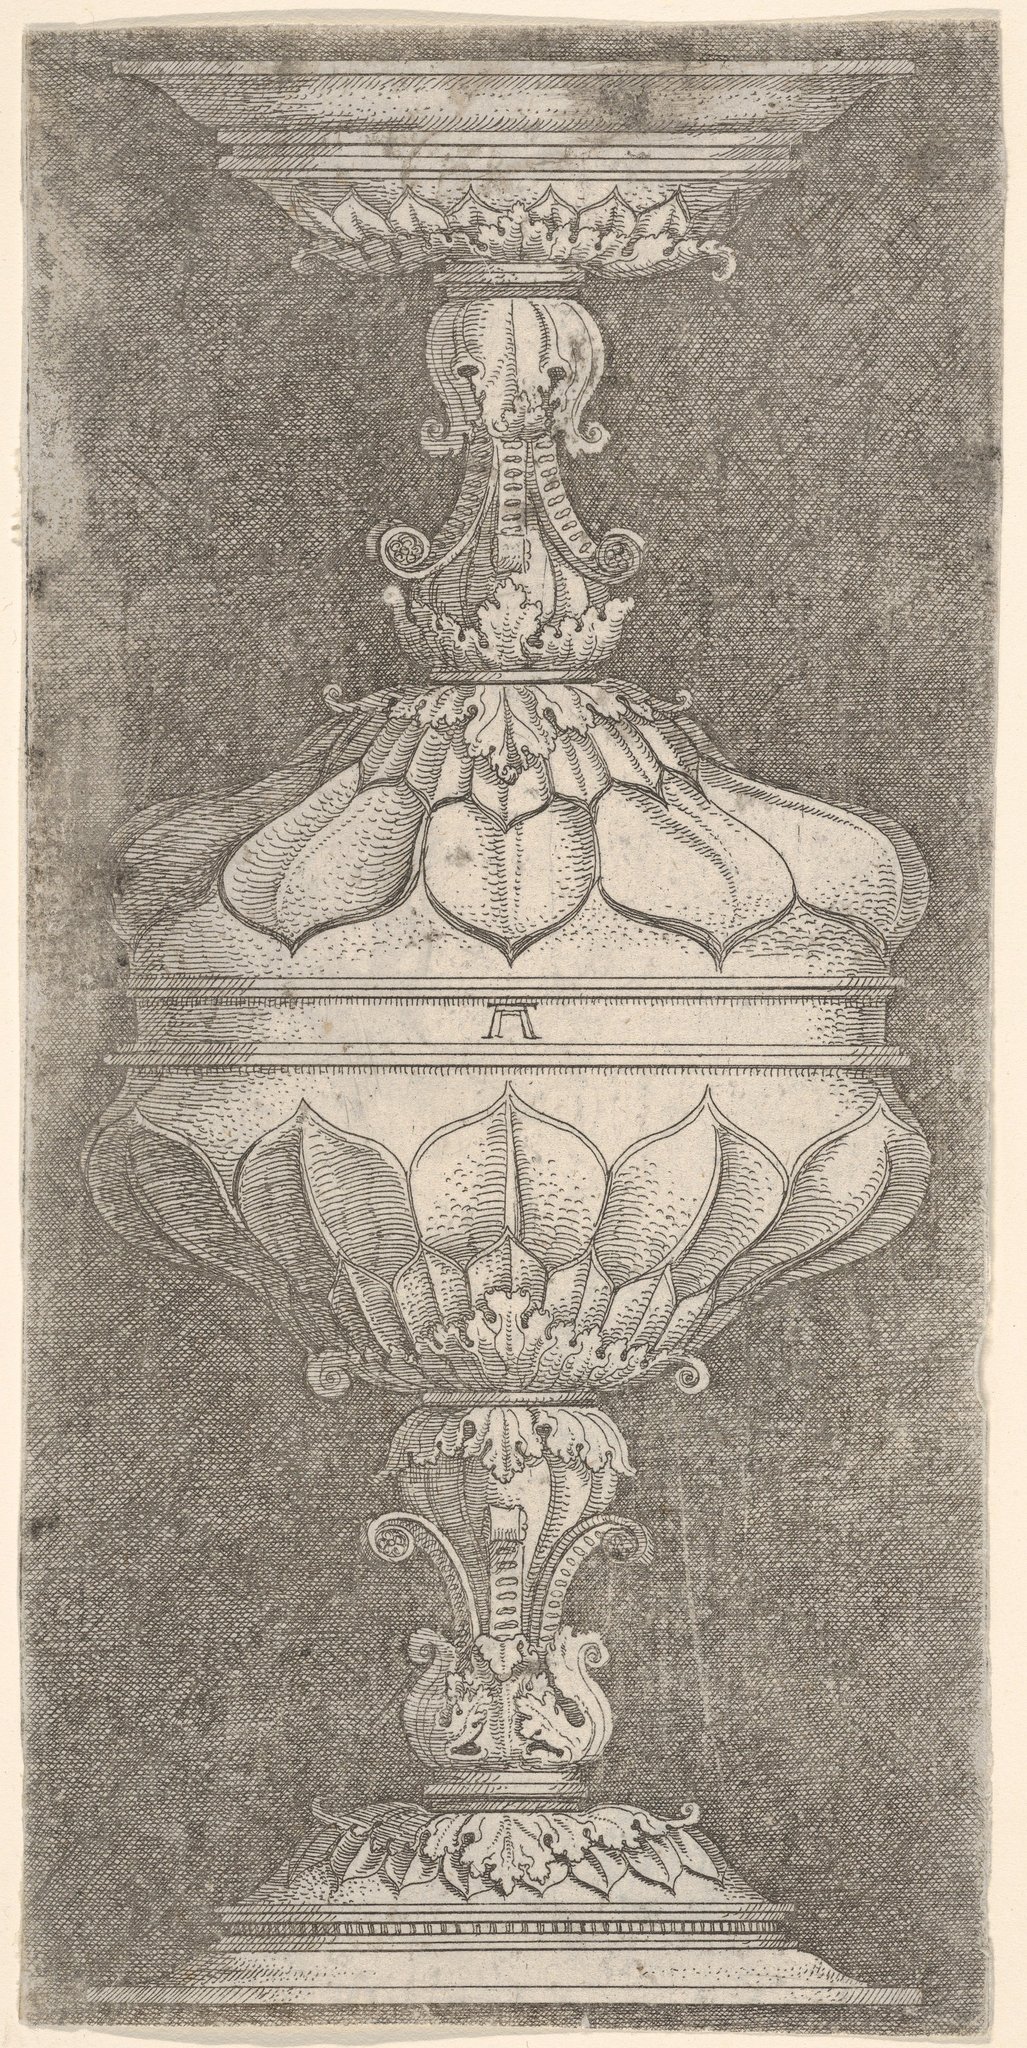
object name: print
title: Double Goblet with Flat Leaves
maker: albrecht altdorfer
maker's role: artist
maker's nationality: german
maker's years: 1480-1538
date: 1500-1538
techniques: etching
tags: drinking glasses